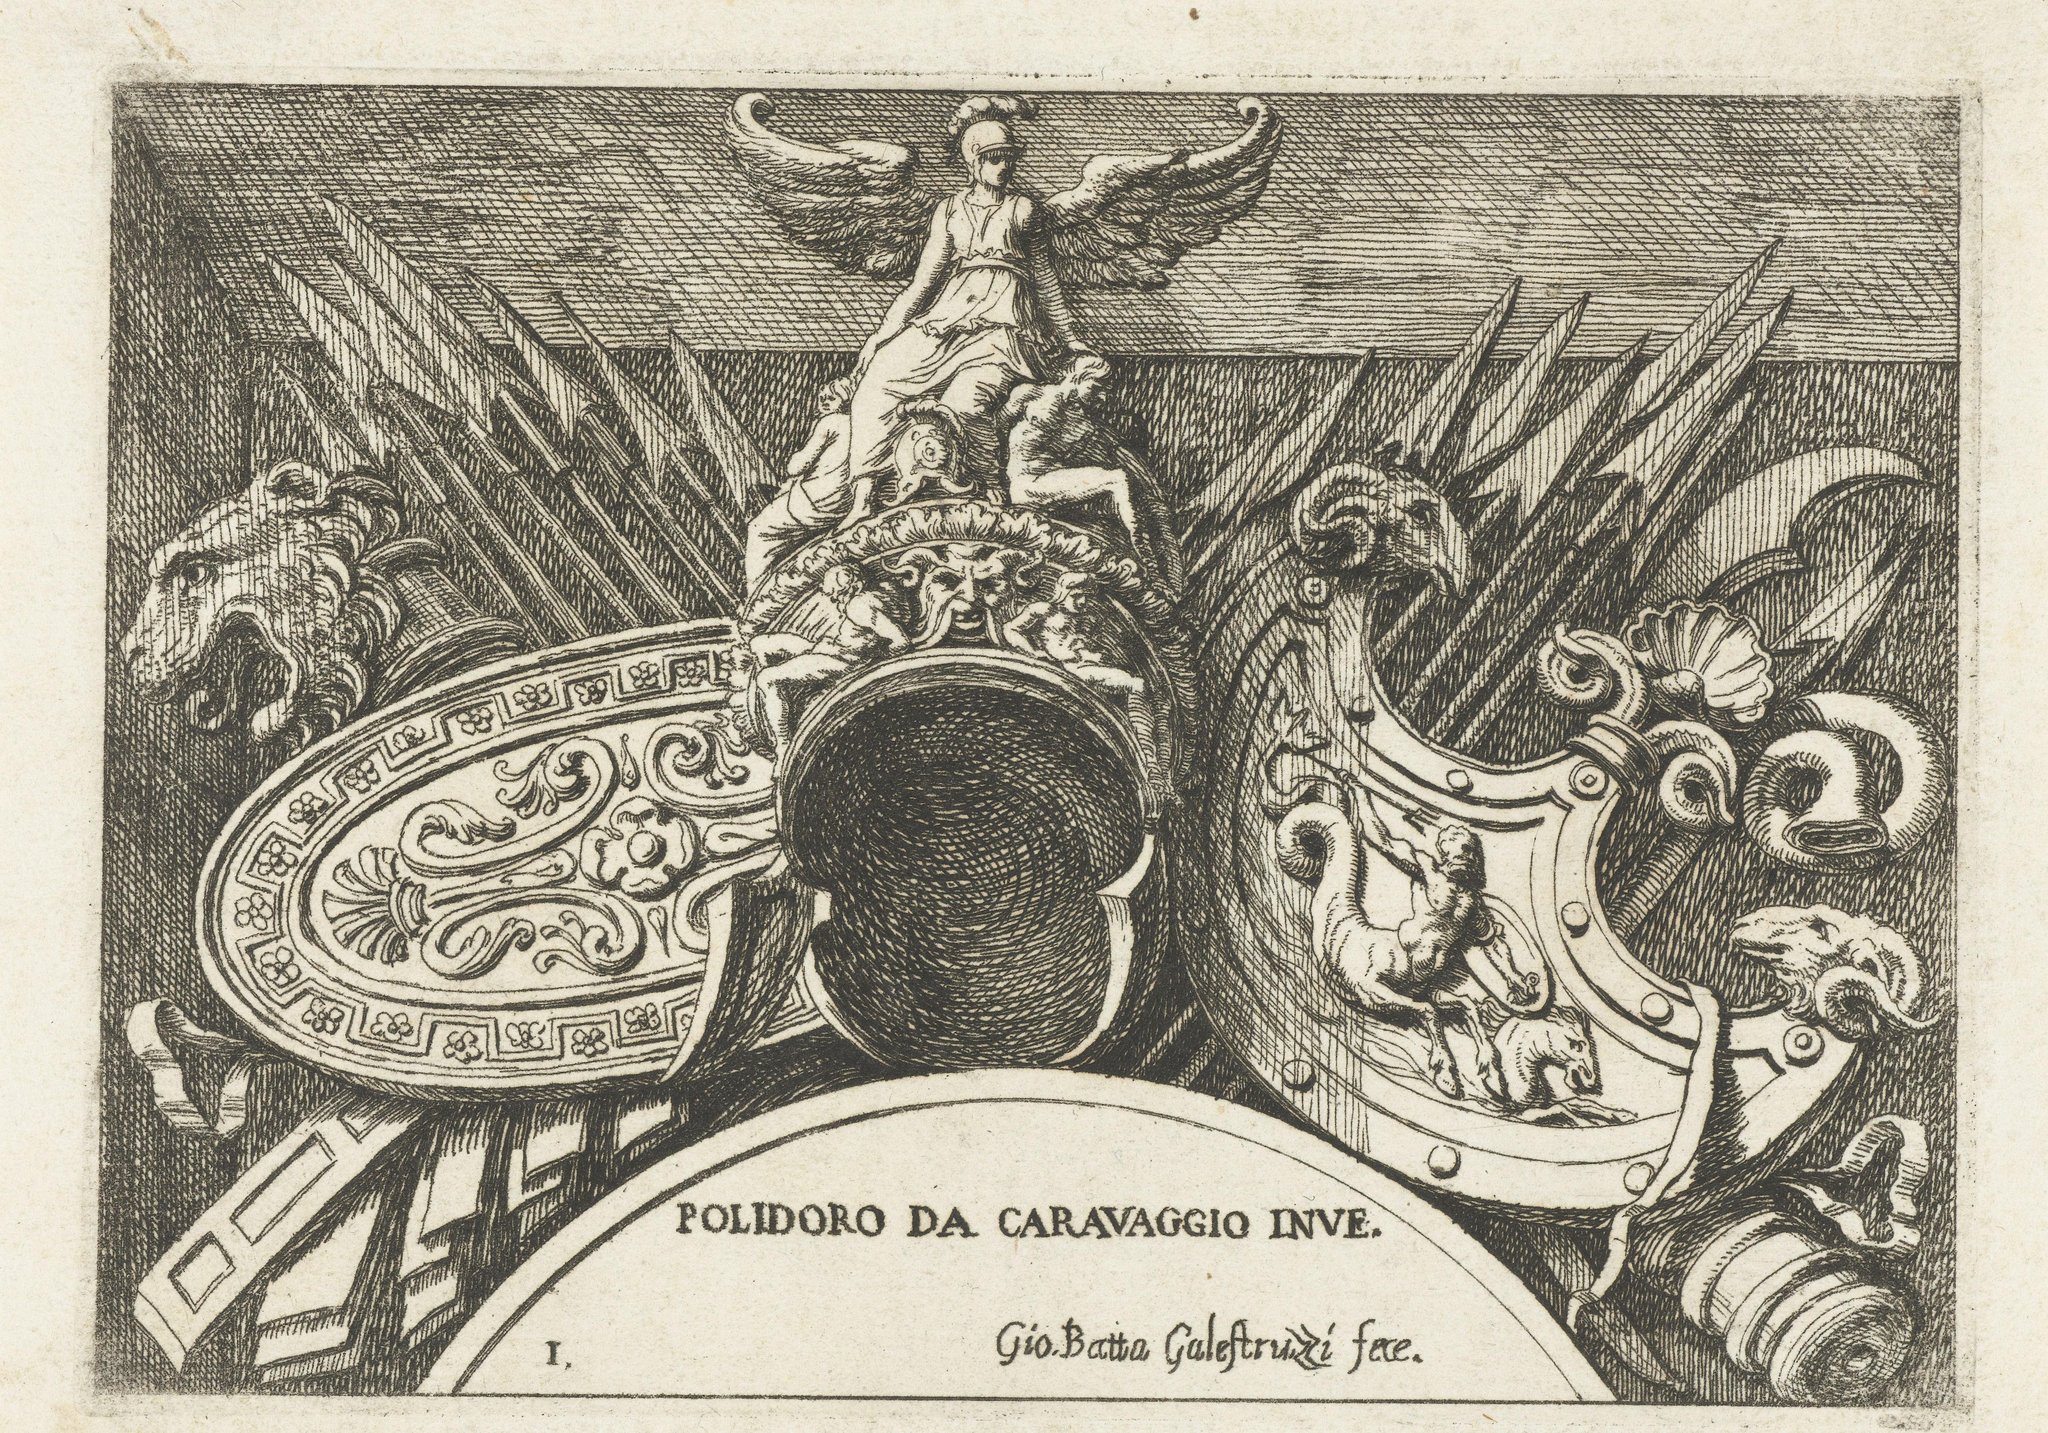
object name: ornament print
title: Helm waarop Nike zit met twee gevangenen aan haar voeten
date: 1658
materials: paper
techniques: etching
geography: italy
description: Wapentrofee, liggend in een vierkante nis. Midden onder bevindt zich een halfrond wit vlak met inscriptie.